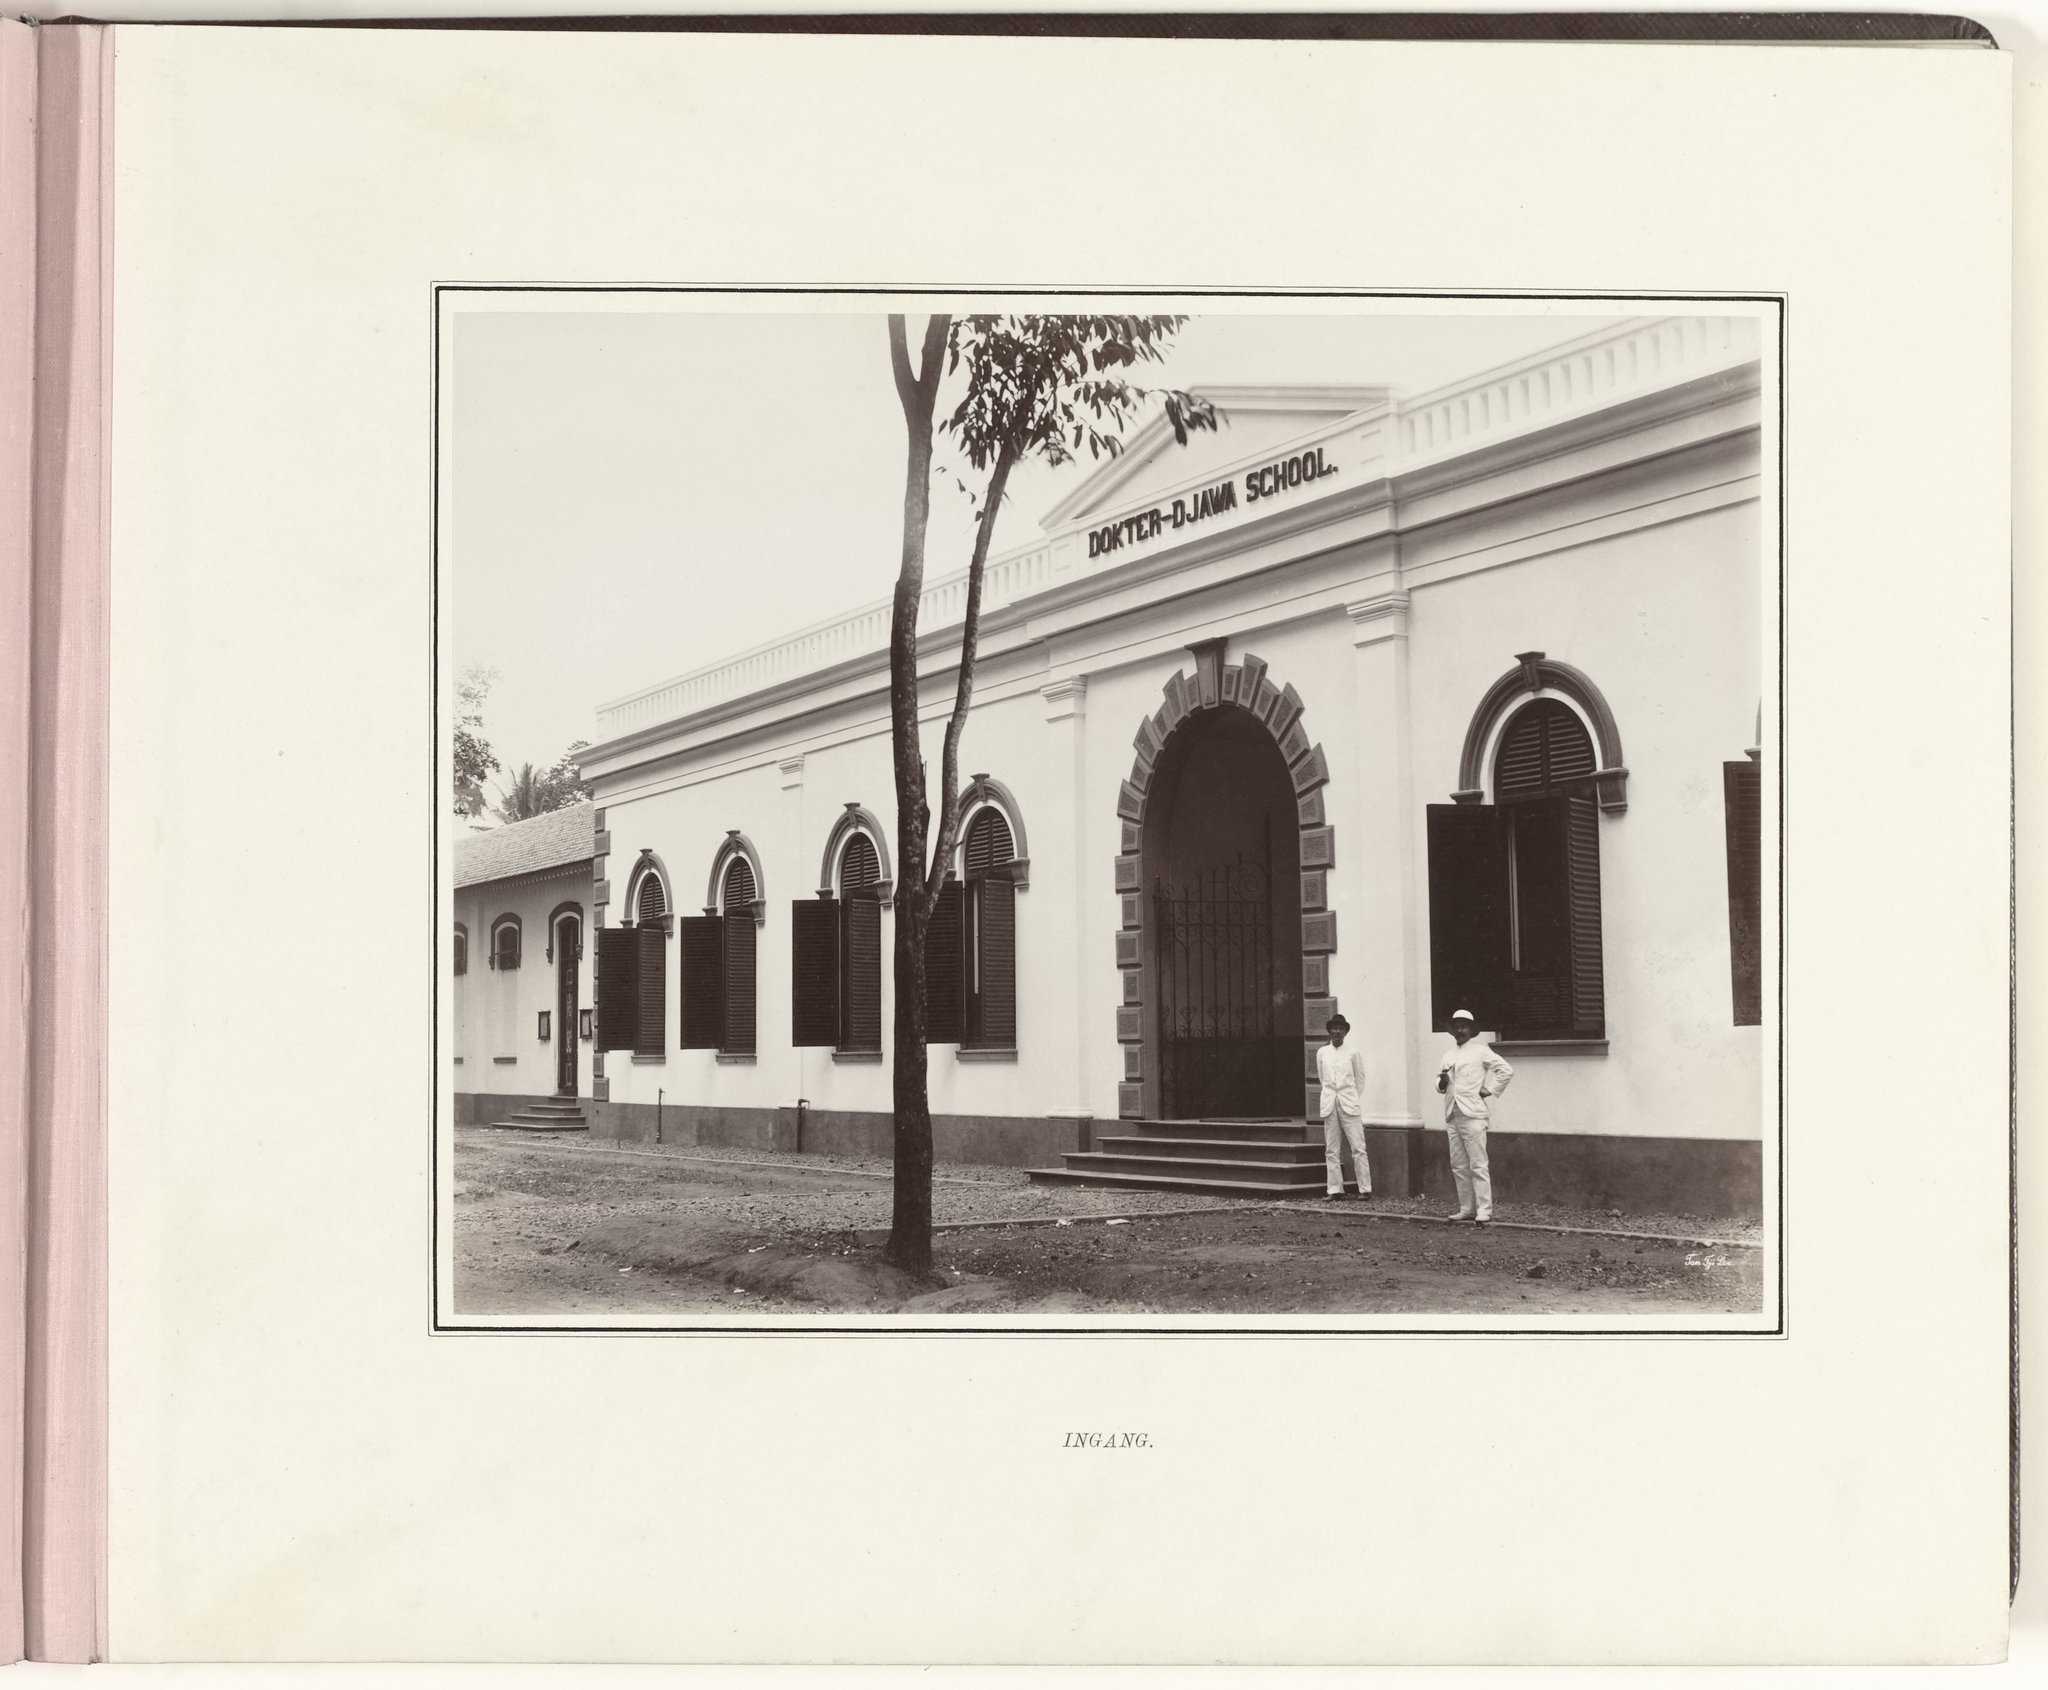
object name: photograph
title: Ingang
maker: tan tjie lan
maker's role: fotograaf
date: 1902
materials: photographic support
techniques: albumen print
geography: weltevreden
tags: colonial system, vocational education, e.g.: junior technical school, vocational education, e.g.: junior technical school (+ building ~ education, tuition)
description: Ingang van de Dokter-Djawa School van de School tot Opleiding van Inlandse Artsen (STOVIA) te Weltevreden. Bij de poort twee staande mannen. Ingeplakte foto in het album van ca. 1902 getiteld: School tot Opleiding van Inlandsche Geneeskundigen / Ter Herinnering aan de Inhuldiging van Koningin Wilhelmina en tot Heil der Bevolking van Nederlandsch Oost-Indie.